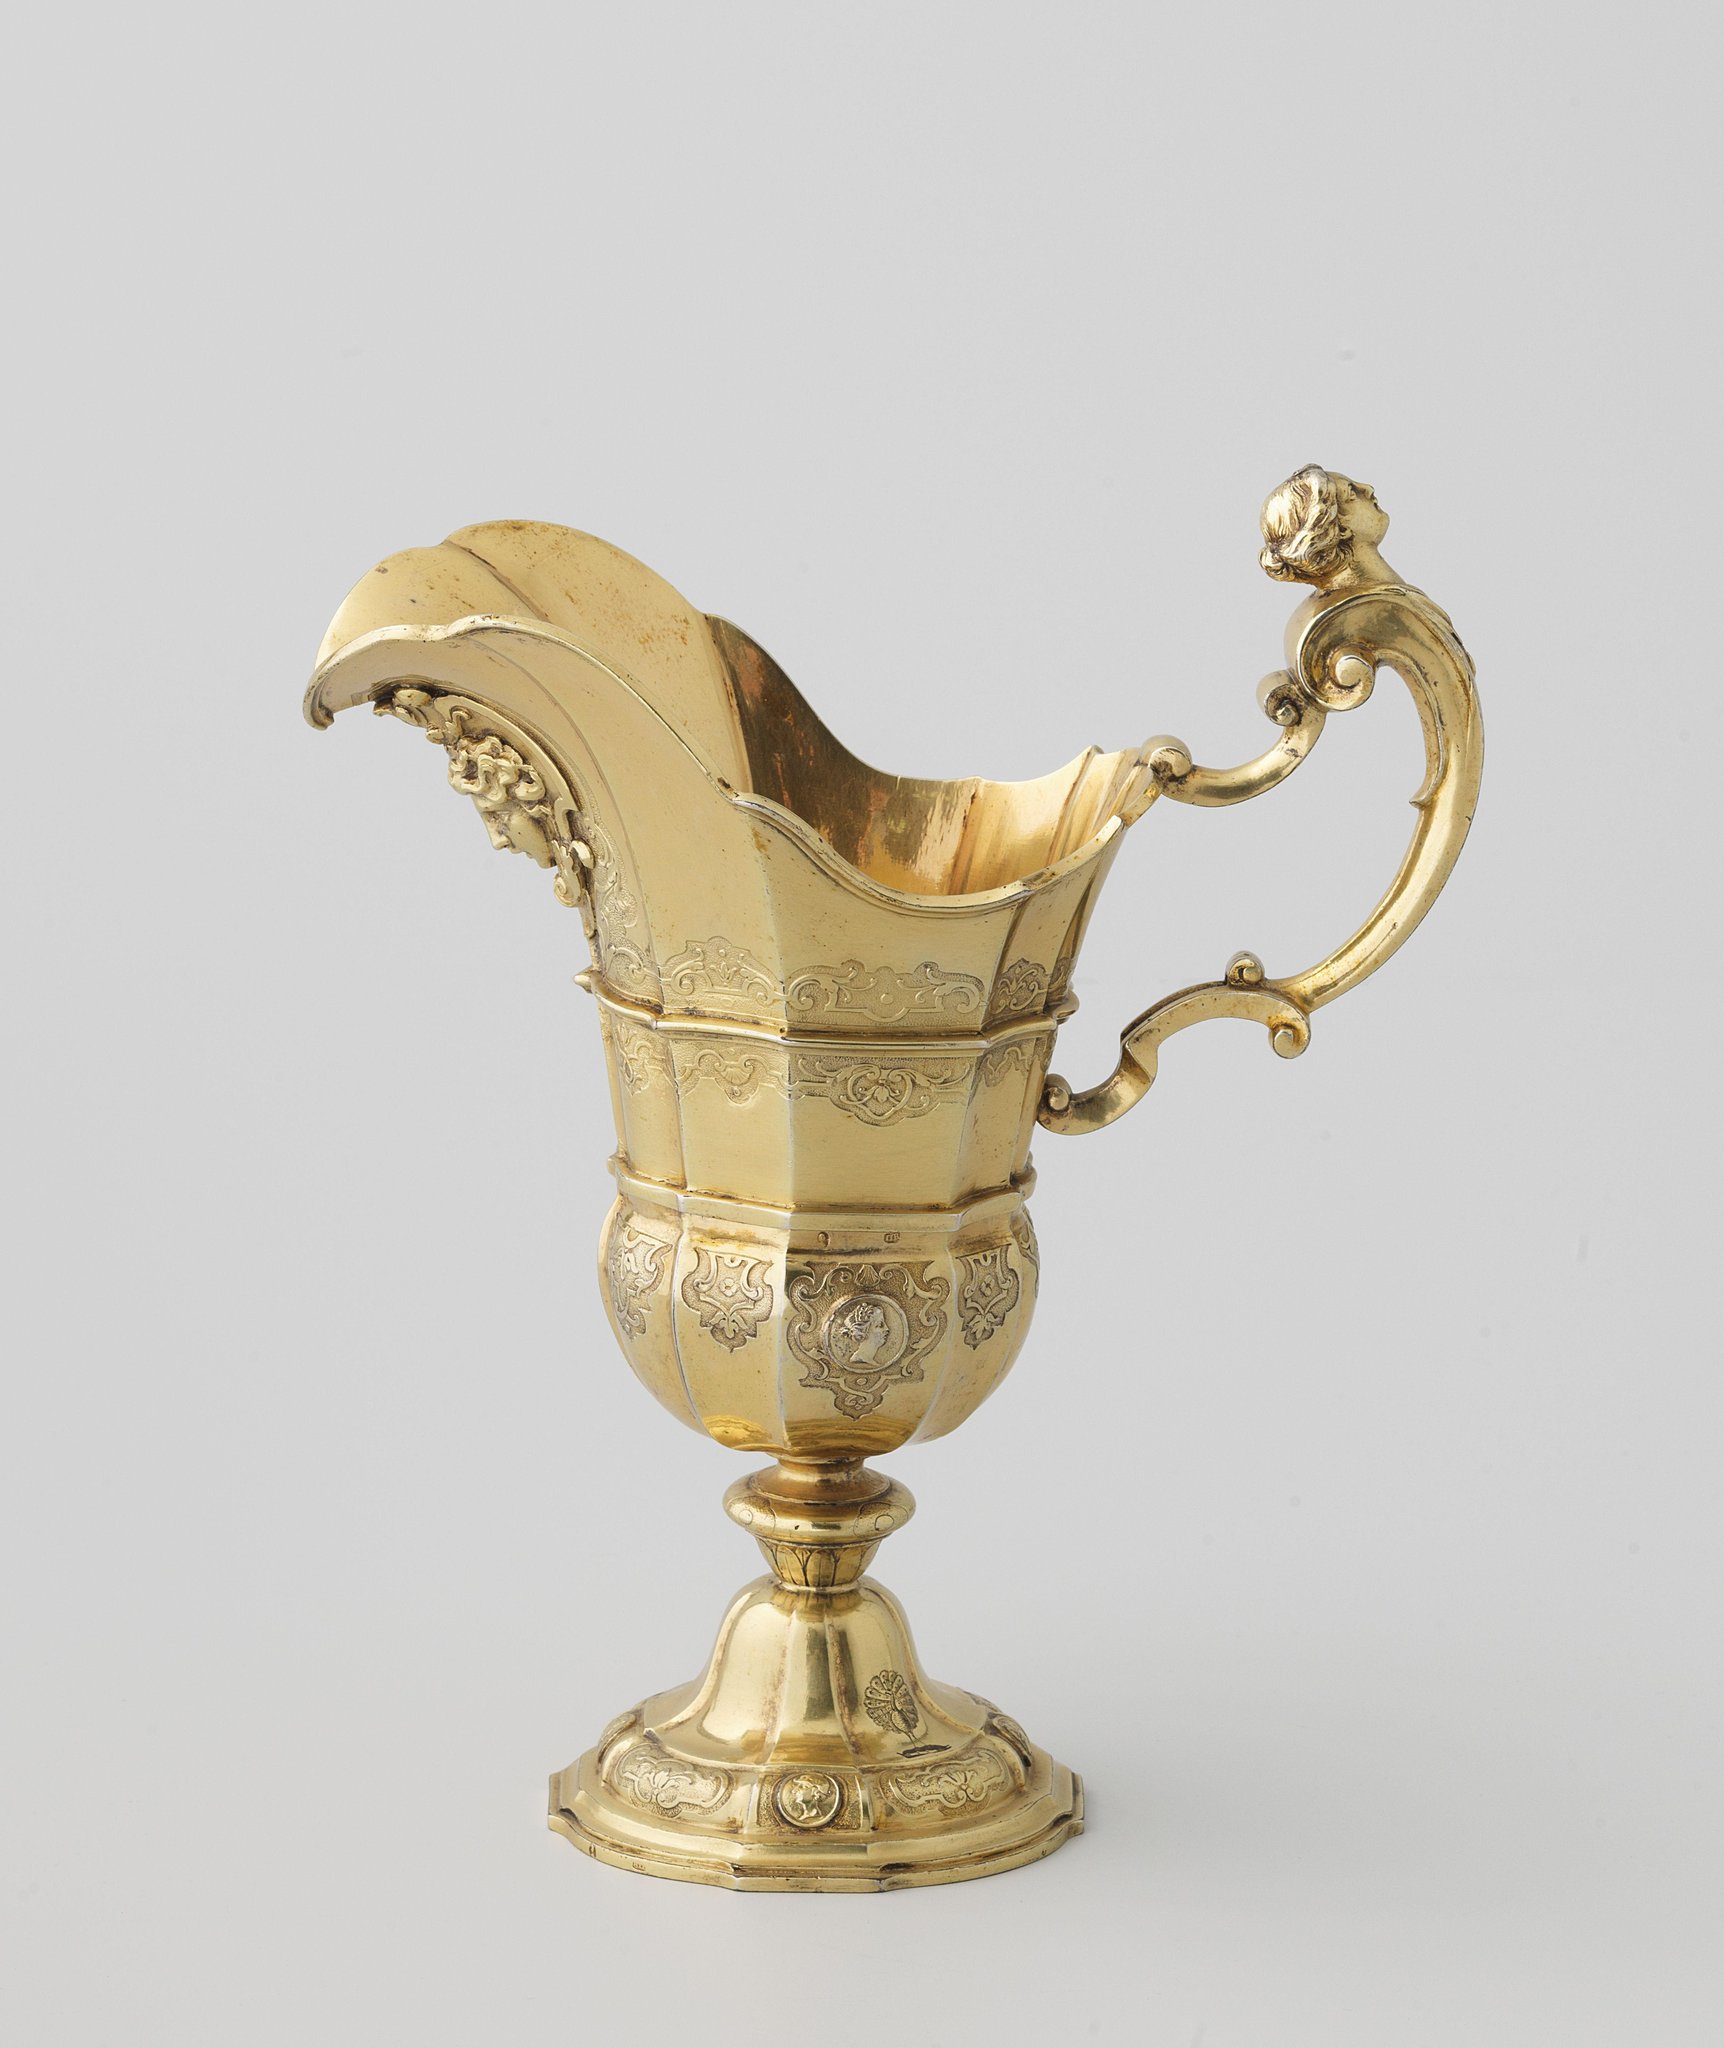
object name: flagon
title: Schenkkan met bandwerk en medaillons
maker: johann jakob bruglocher (ii)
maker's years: 1678-1752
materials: silver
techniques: gilding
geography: augsburg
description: Schenkkan van verguld zilver, op hoge voet. De kan heeft een brede tuit en een hoog oor. Versierd met bandwerk en medaillons.